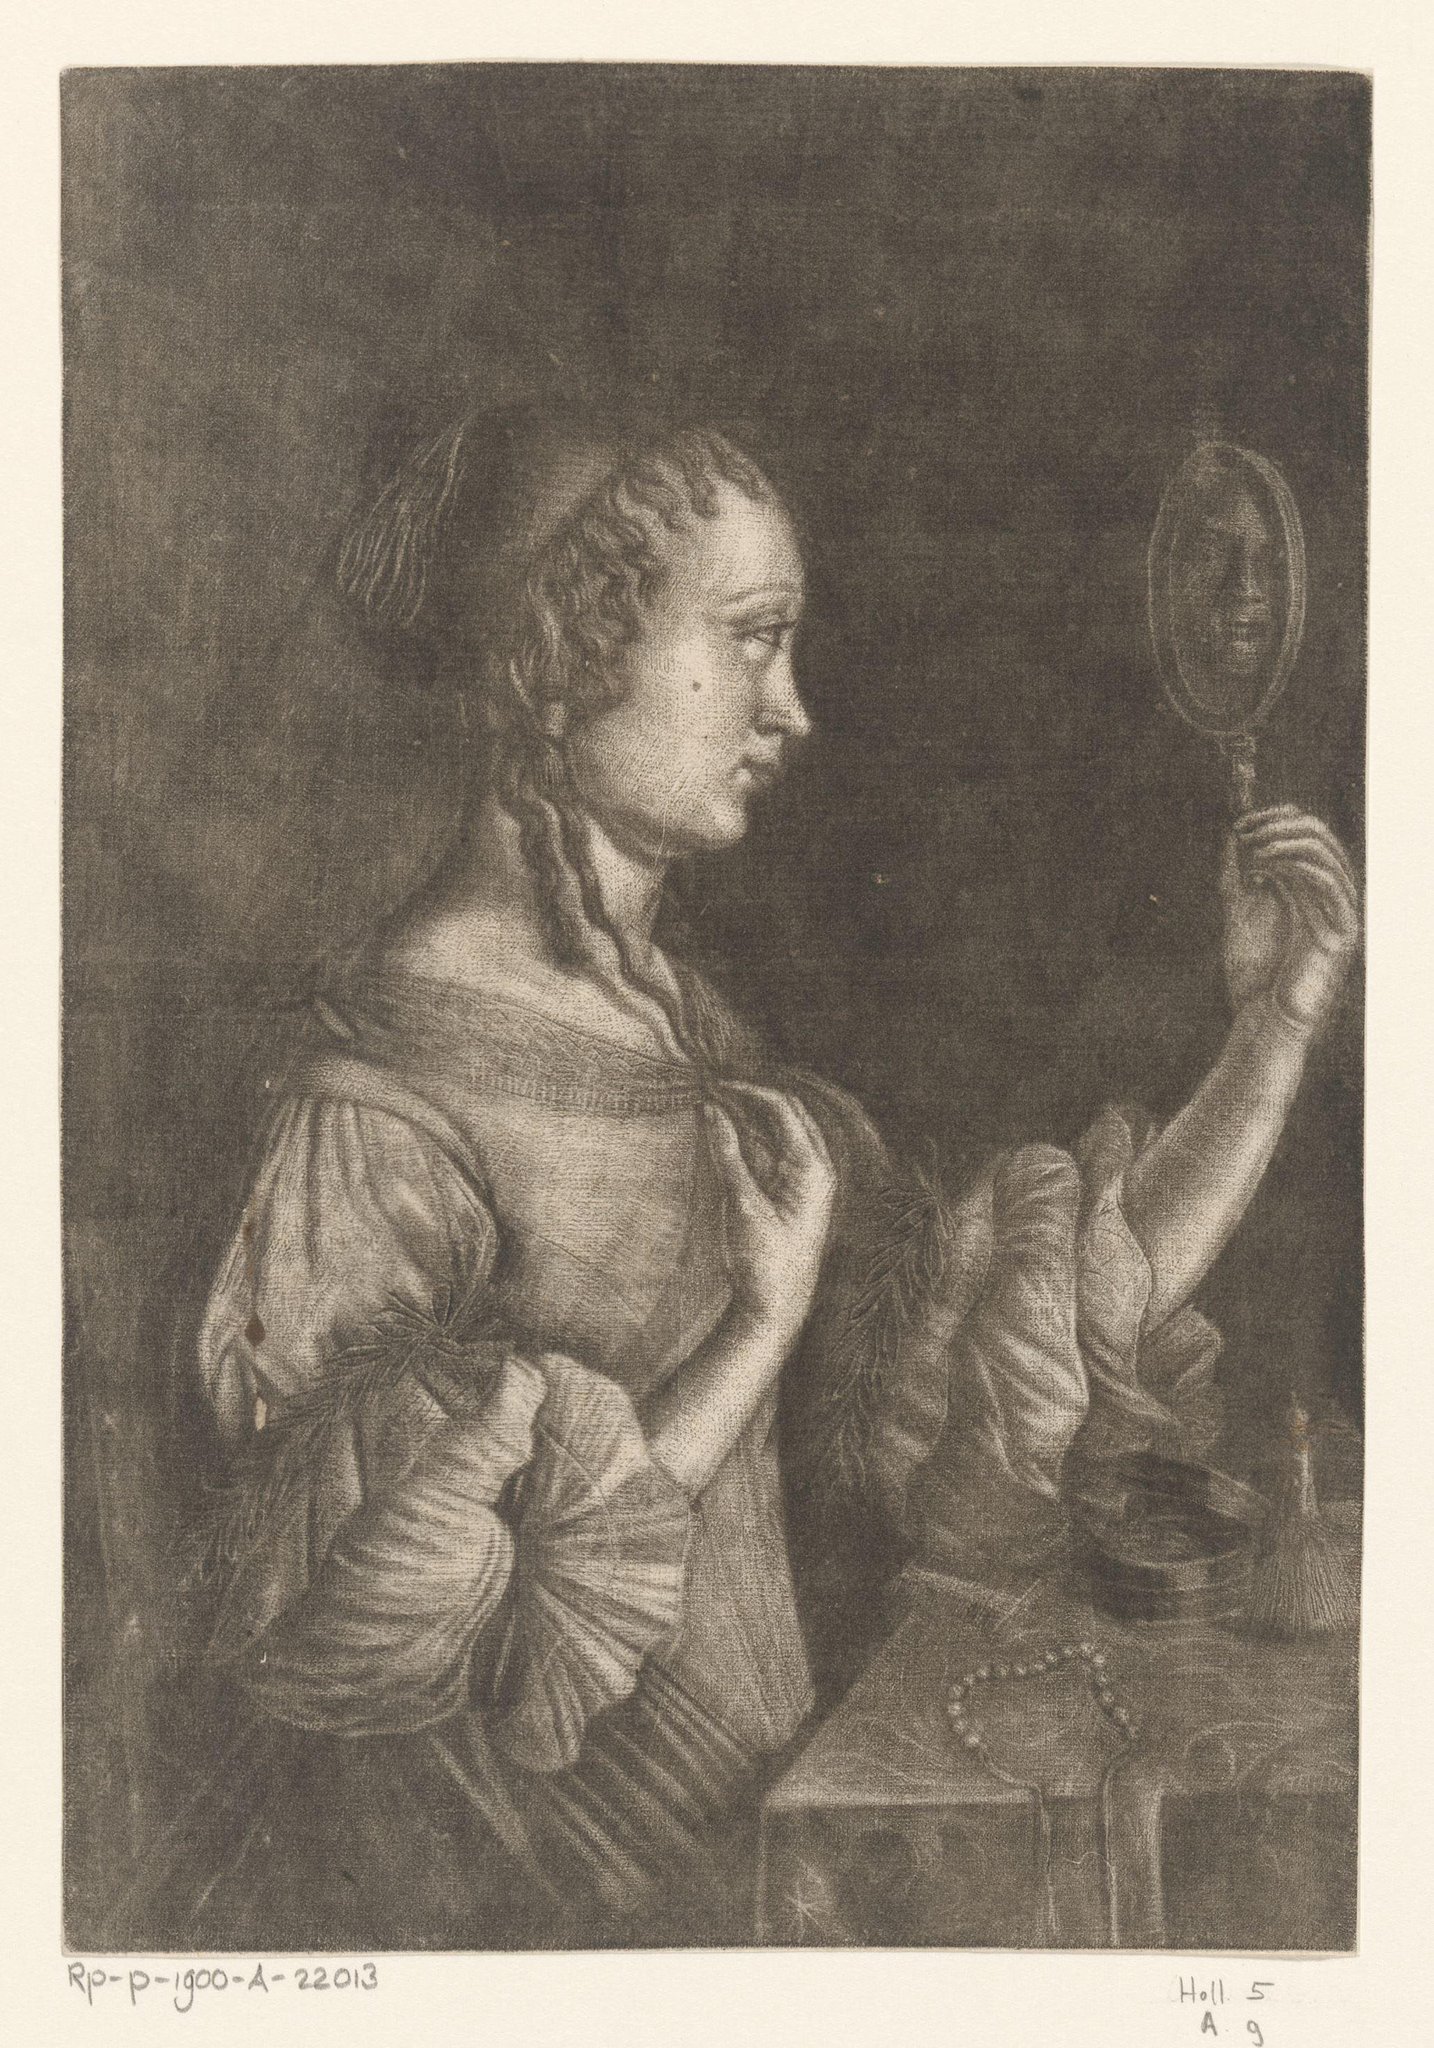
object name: print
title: Meisje met spiegel in de hand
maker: martin dichtl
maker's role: painter, print maker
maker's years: 1639-1710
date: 1649-1710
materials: paper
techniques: mezzotint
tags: making toilet, mirror, girl (child between toddler and youth)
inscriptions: collector's mark: Lugt 2228